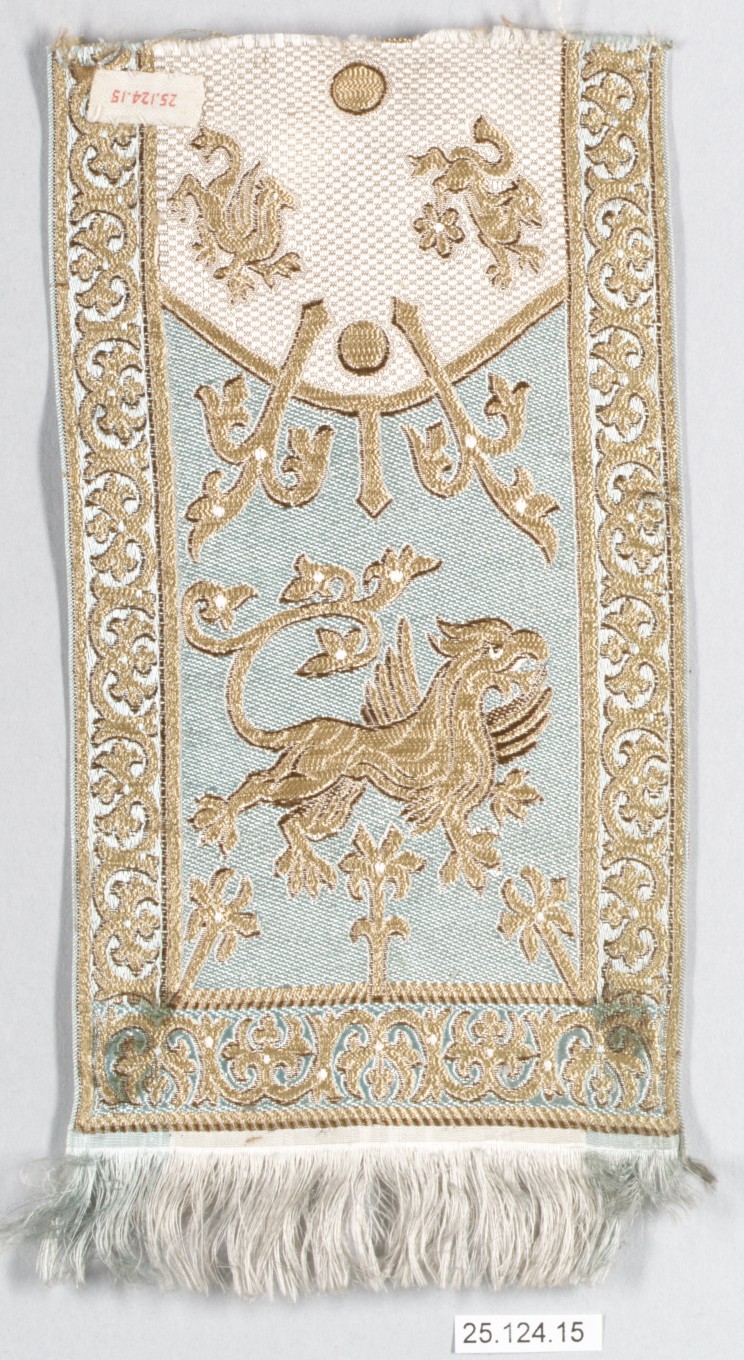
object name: necktie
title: Woman's necktie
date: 1870-1880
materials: silk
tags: griffins